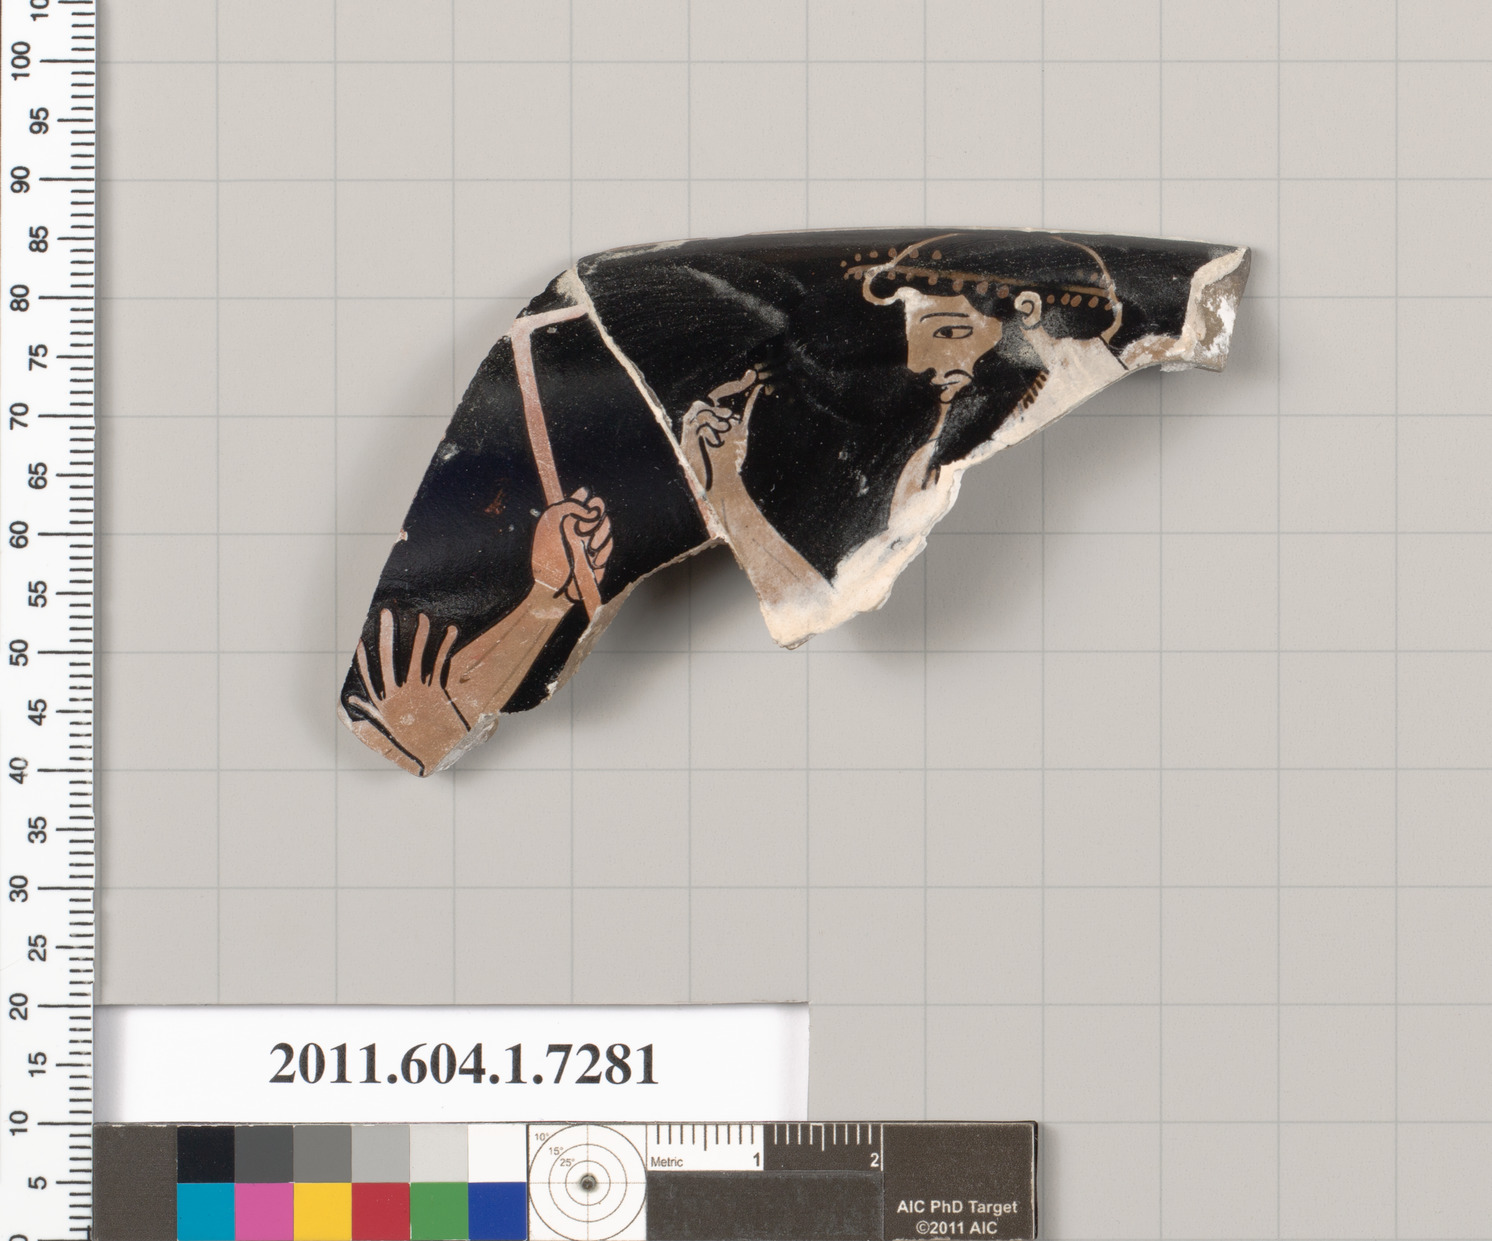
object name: kylix fragment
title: Terracotta rim fragment of a kylix (drinking cup)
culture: greek, attic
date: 500-480 BCE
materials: terracotta